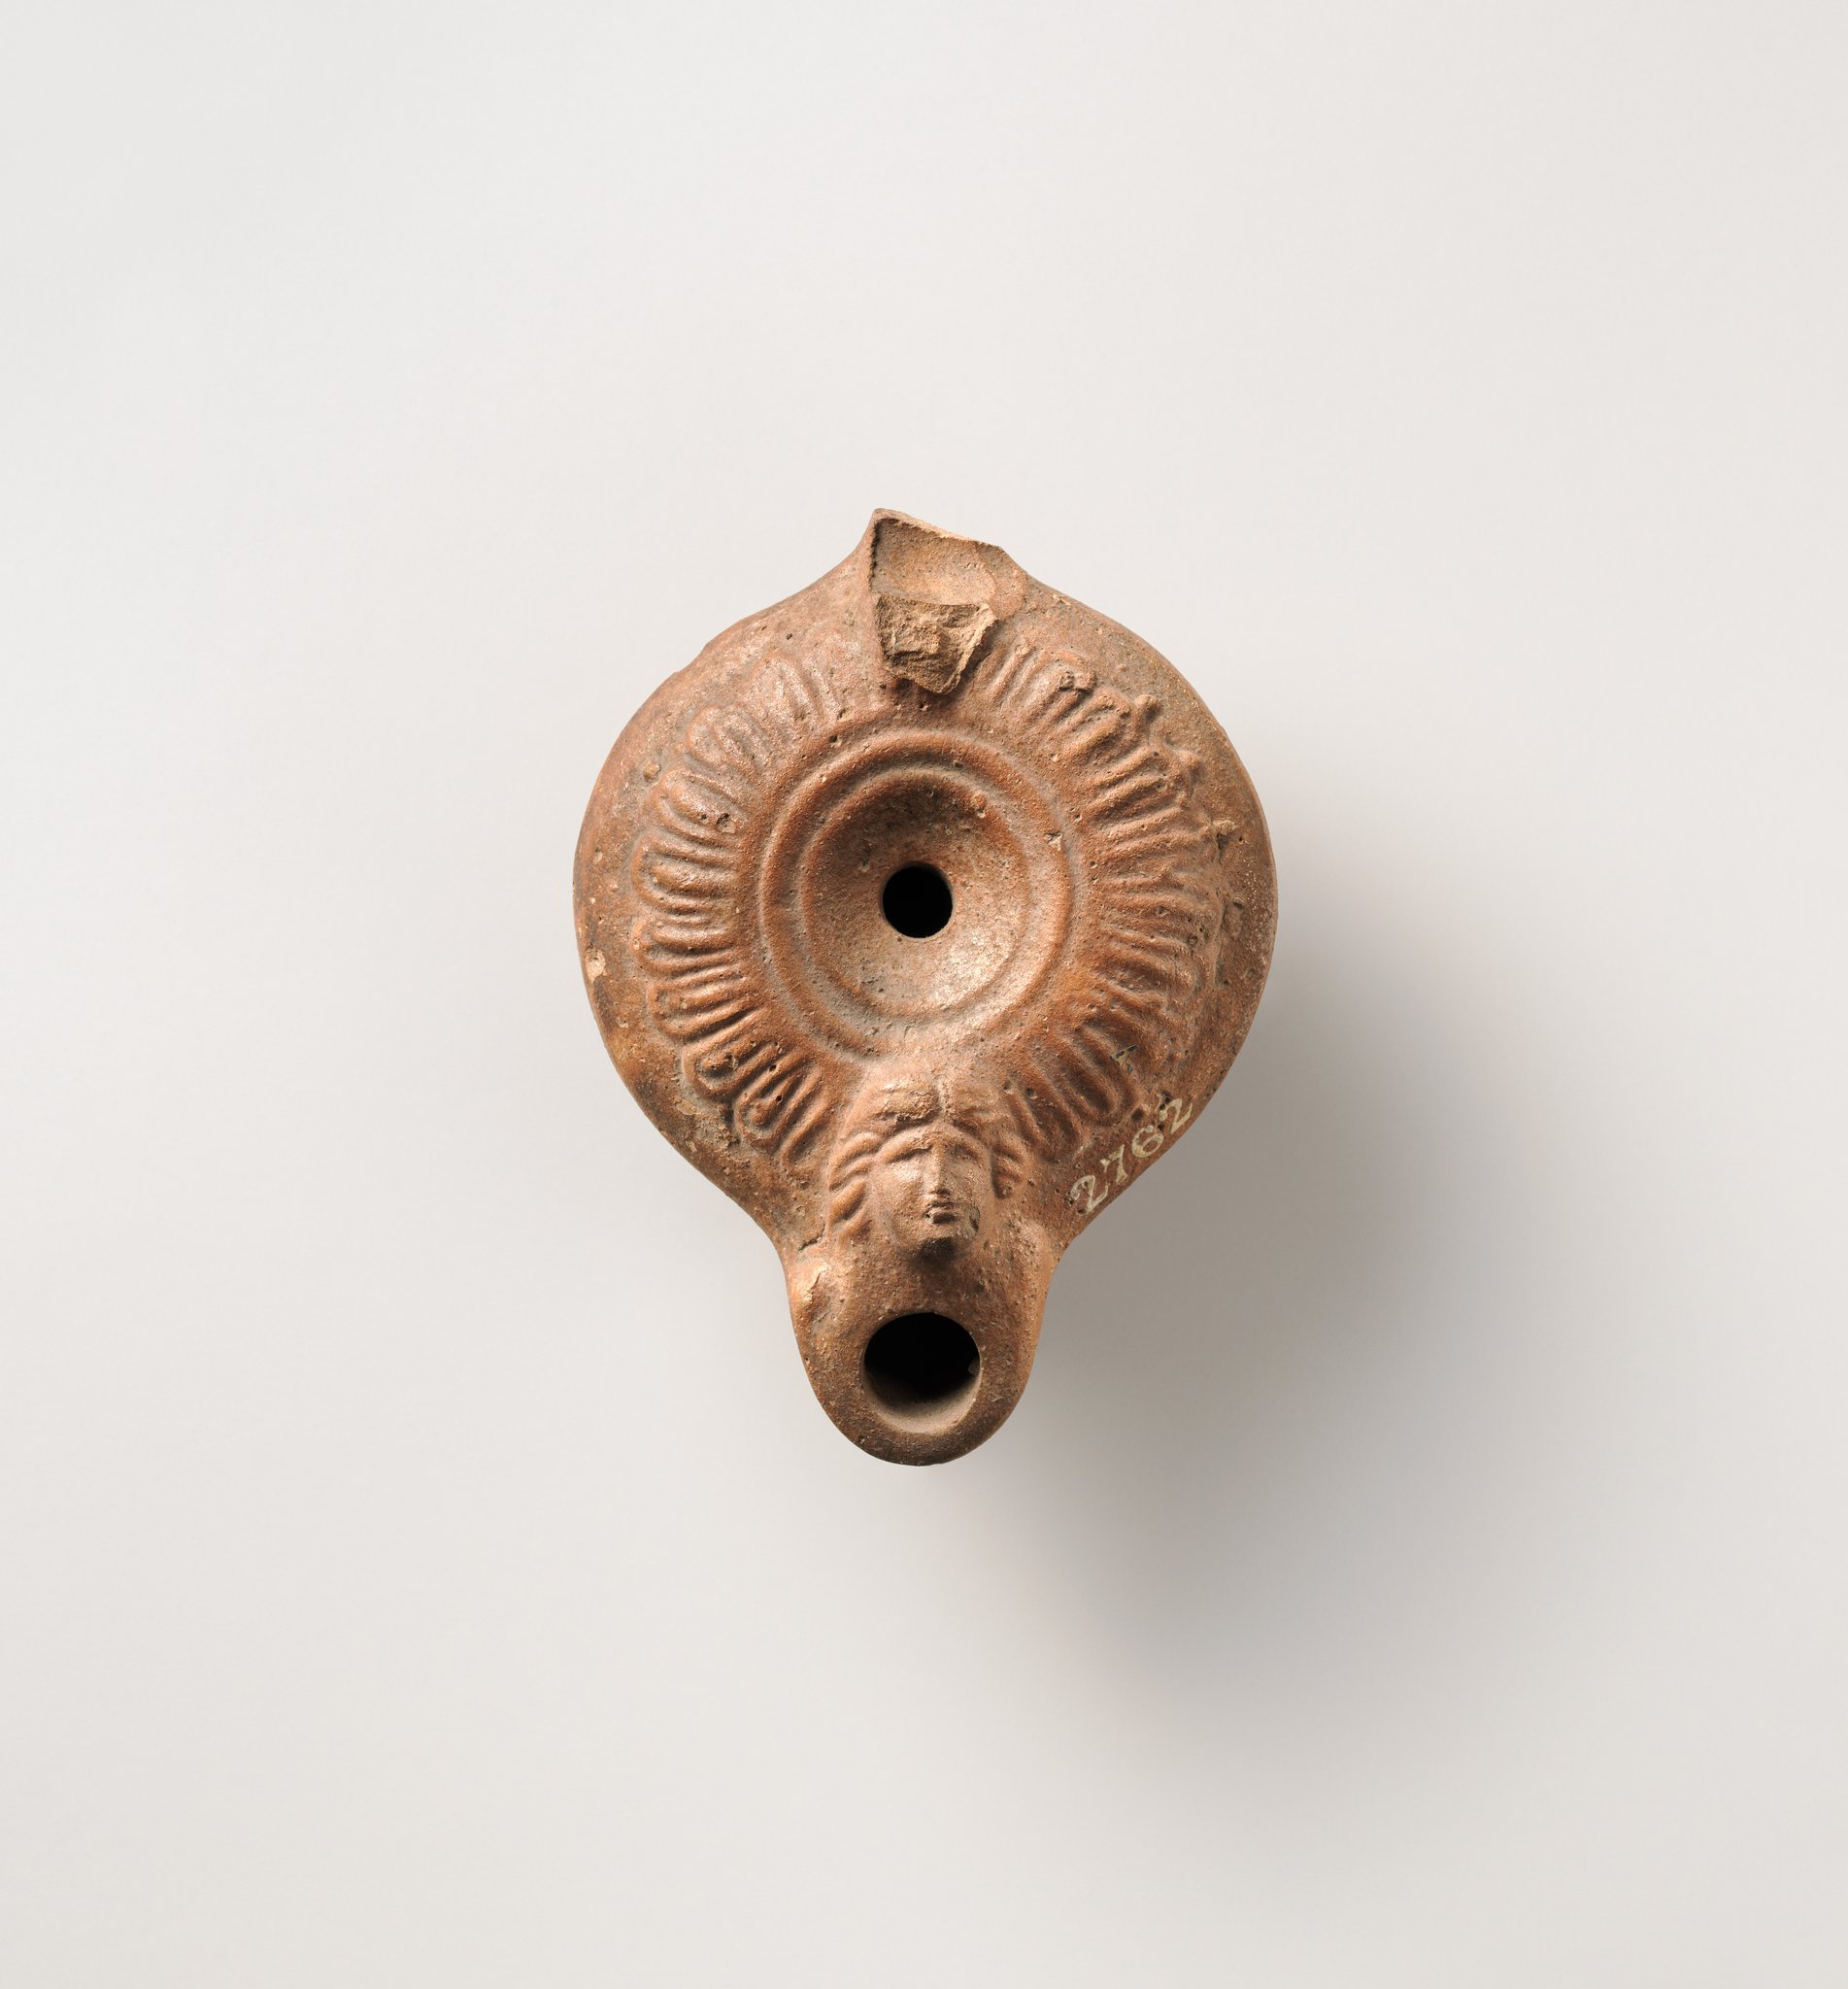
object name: lamp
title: Terracotta oil lamp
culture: roman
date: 101-200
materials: terracotta